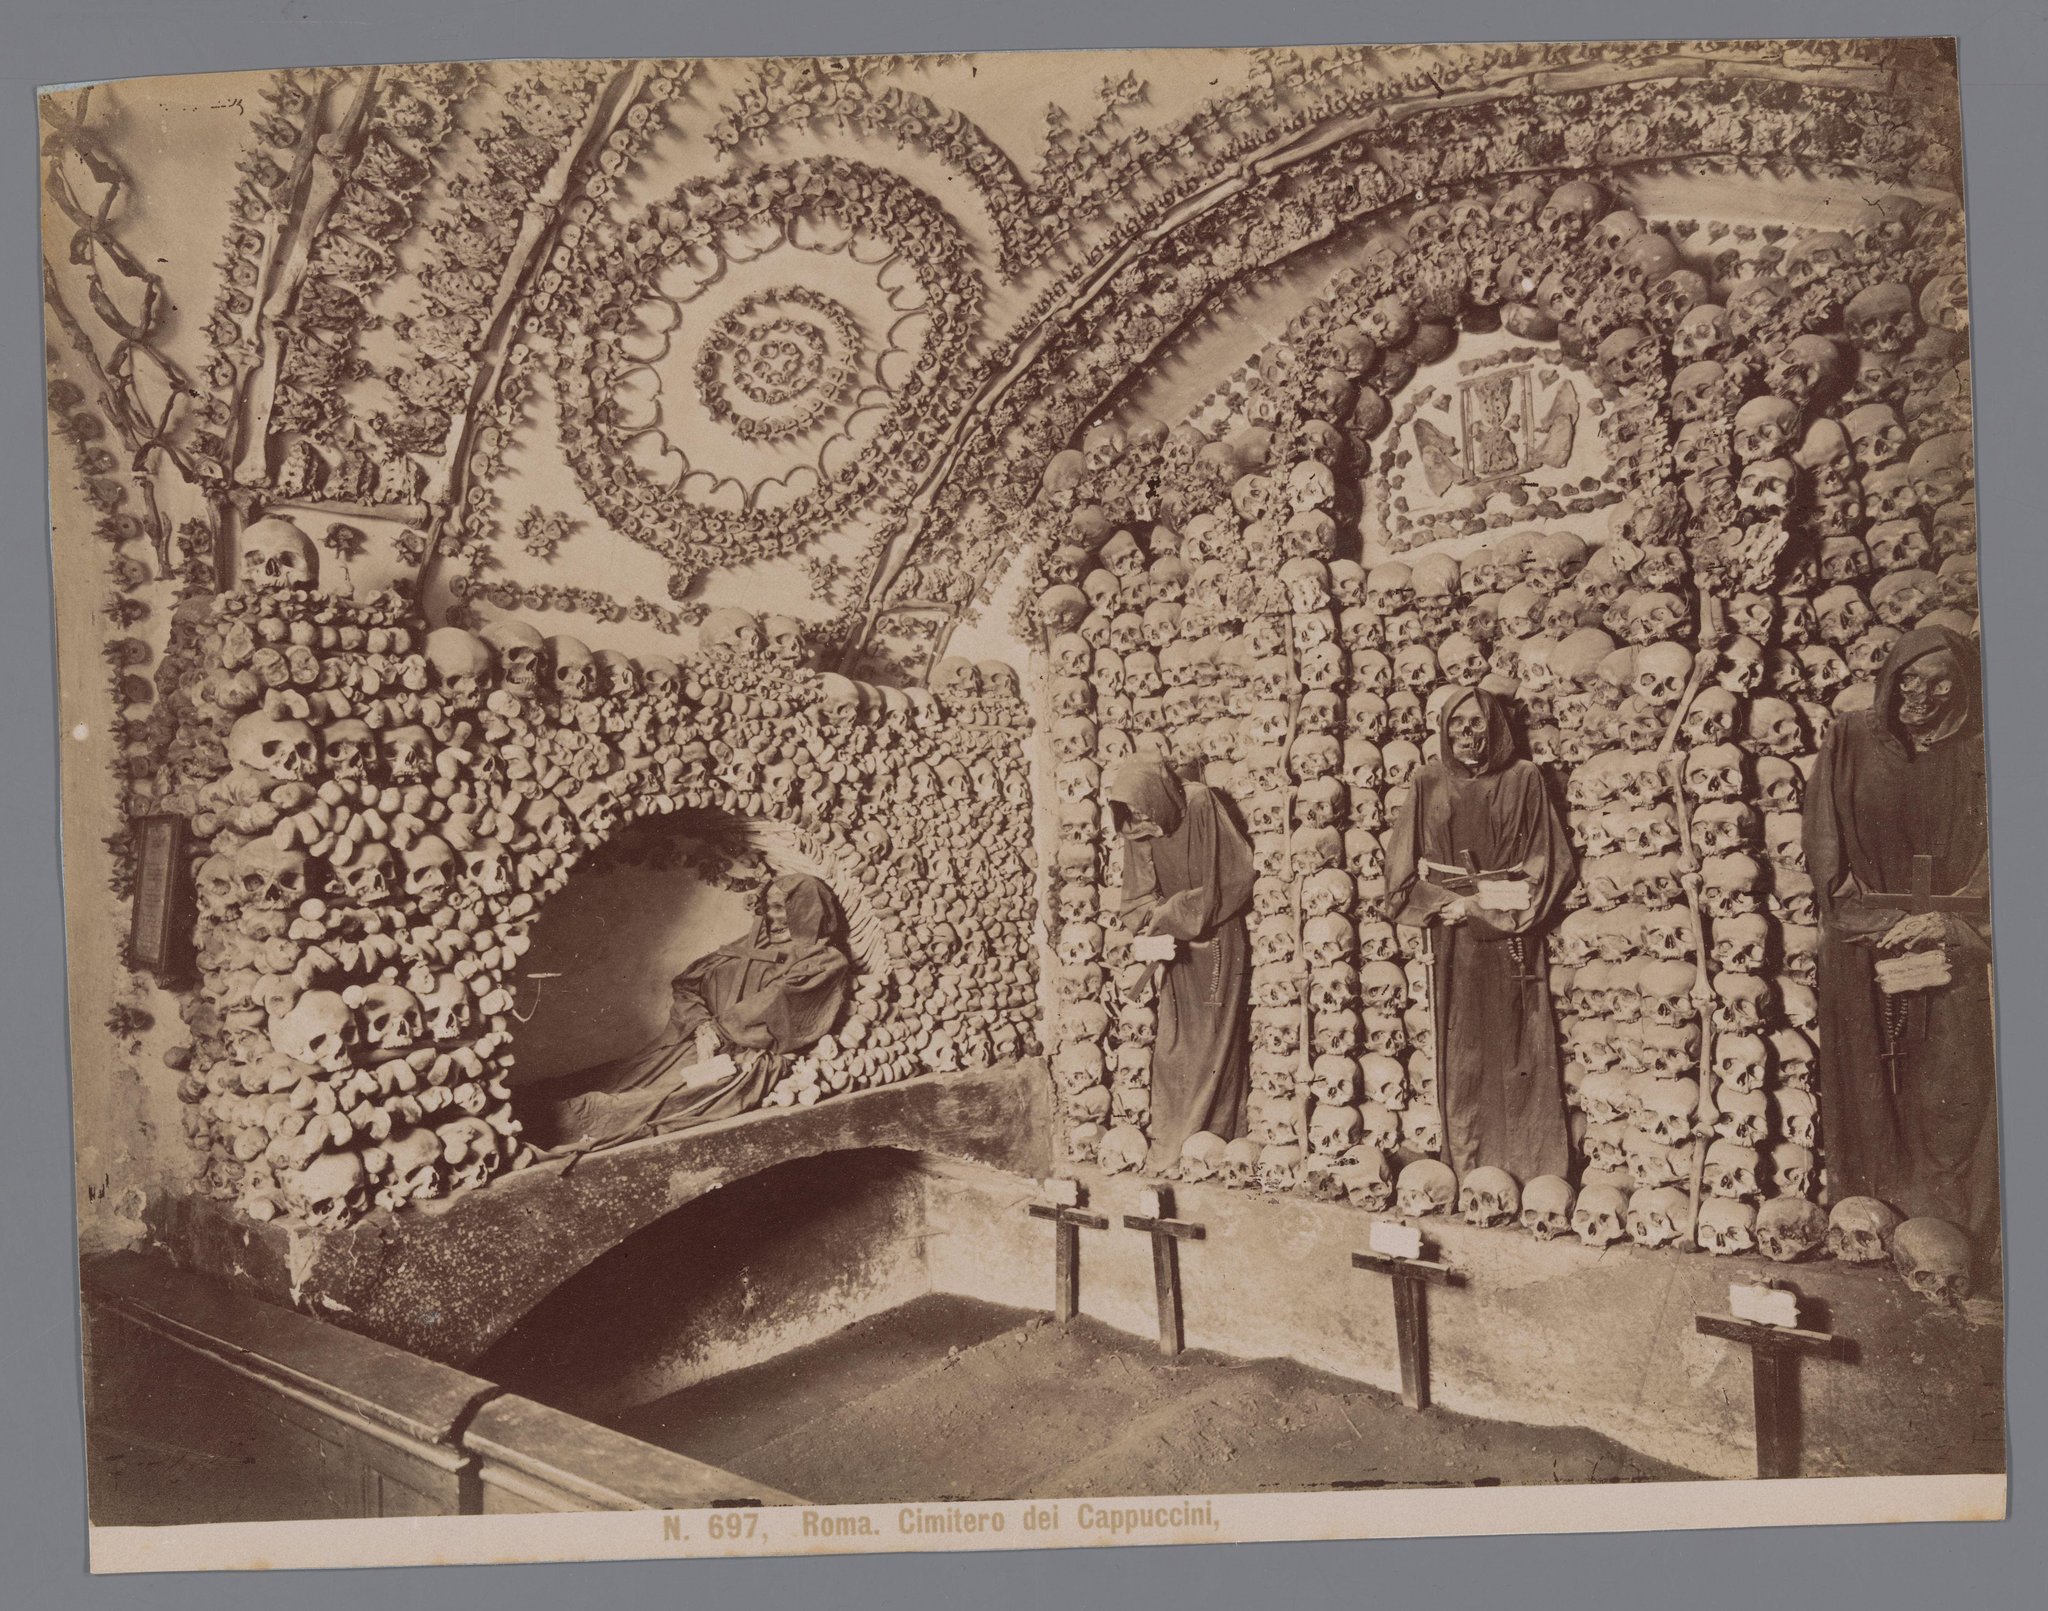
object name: photograph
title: Interieur van de Santa Maria della Concezione dei Cappuccini te Rome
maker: Anonymous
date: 1851-1900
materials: paper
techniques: albumen print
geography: rome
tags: parts of church interior (crypt), rome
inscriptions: number: ‘N. 697,’